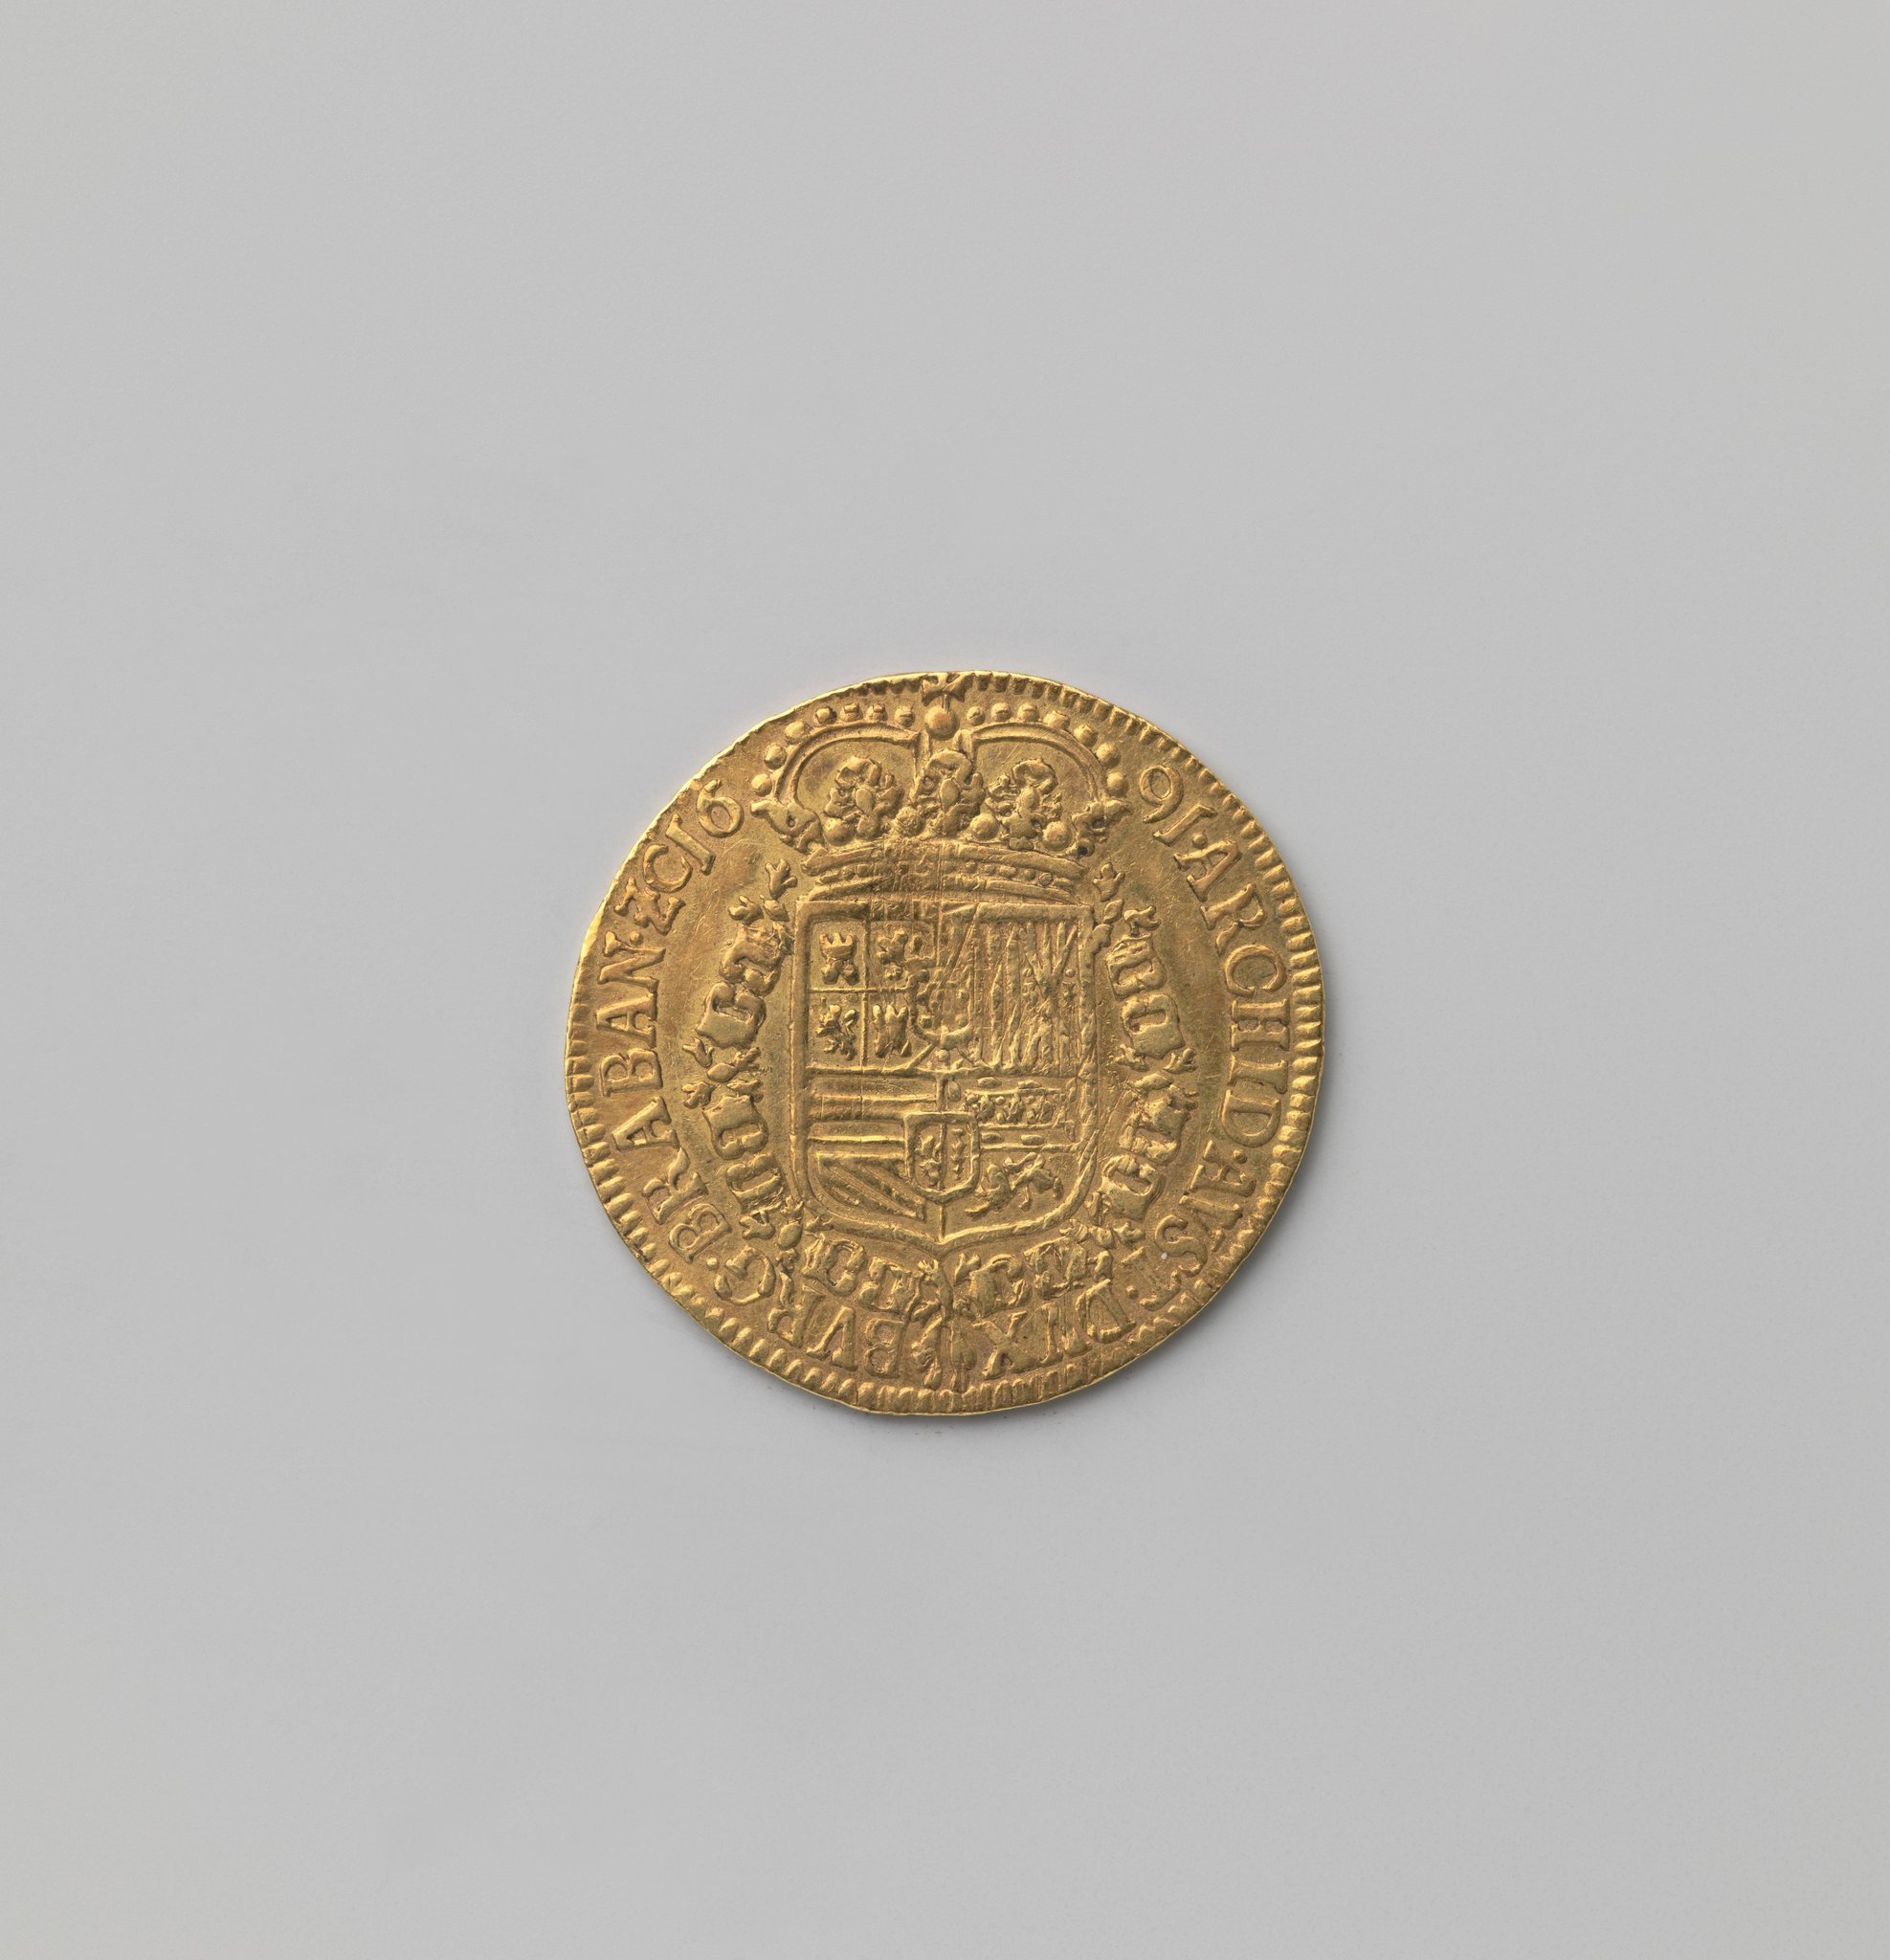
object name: soeverein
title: Brabant, Karel II, soeverein, 1691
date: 1691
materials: gold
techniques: striking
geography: brussels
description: Gouden munt. Voorzijde: staande leeuw naar links, met linker klauw een op sokkel geplaatste aardbol vasthoudend, in rechter klauw zwaard, waarboven engelenkop. Keerzijde: door keten van het gulden vlies omhangen gekroond samengesteld wapenschild. Jaartal in omschrift rondom kroon.